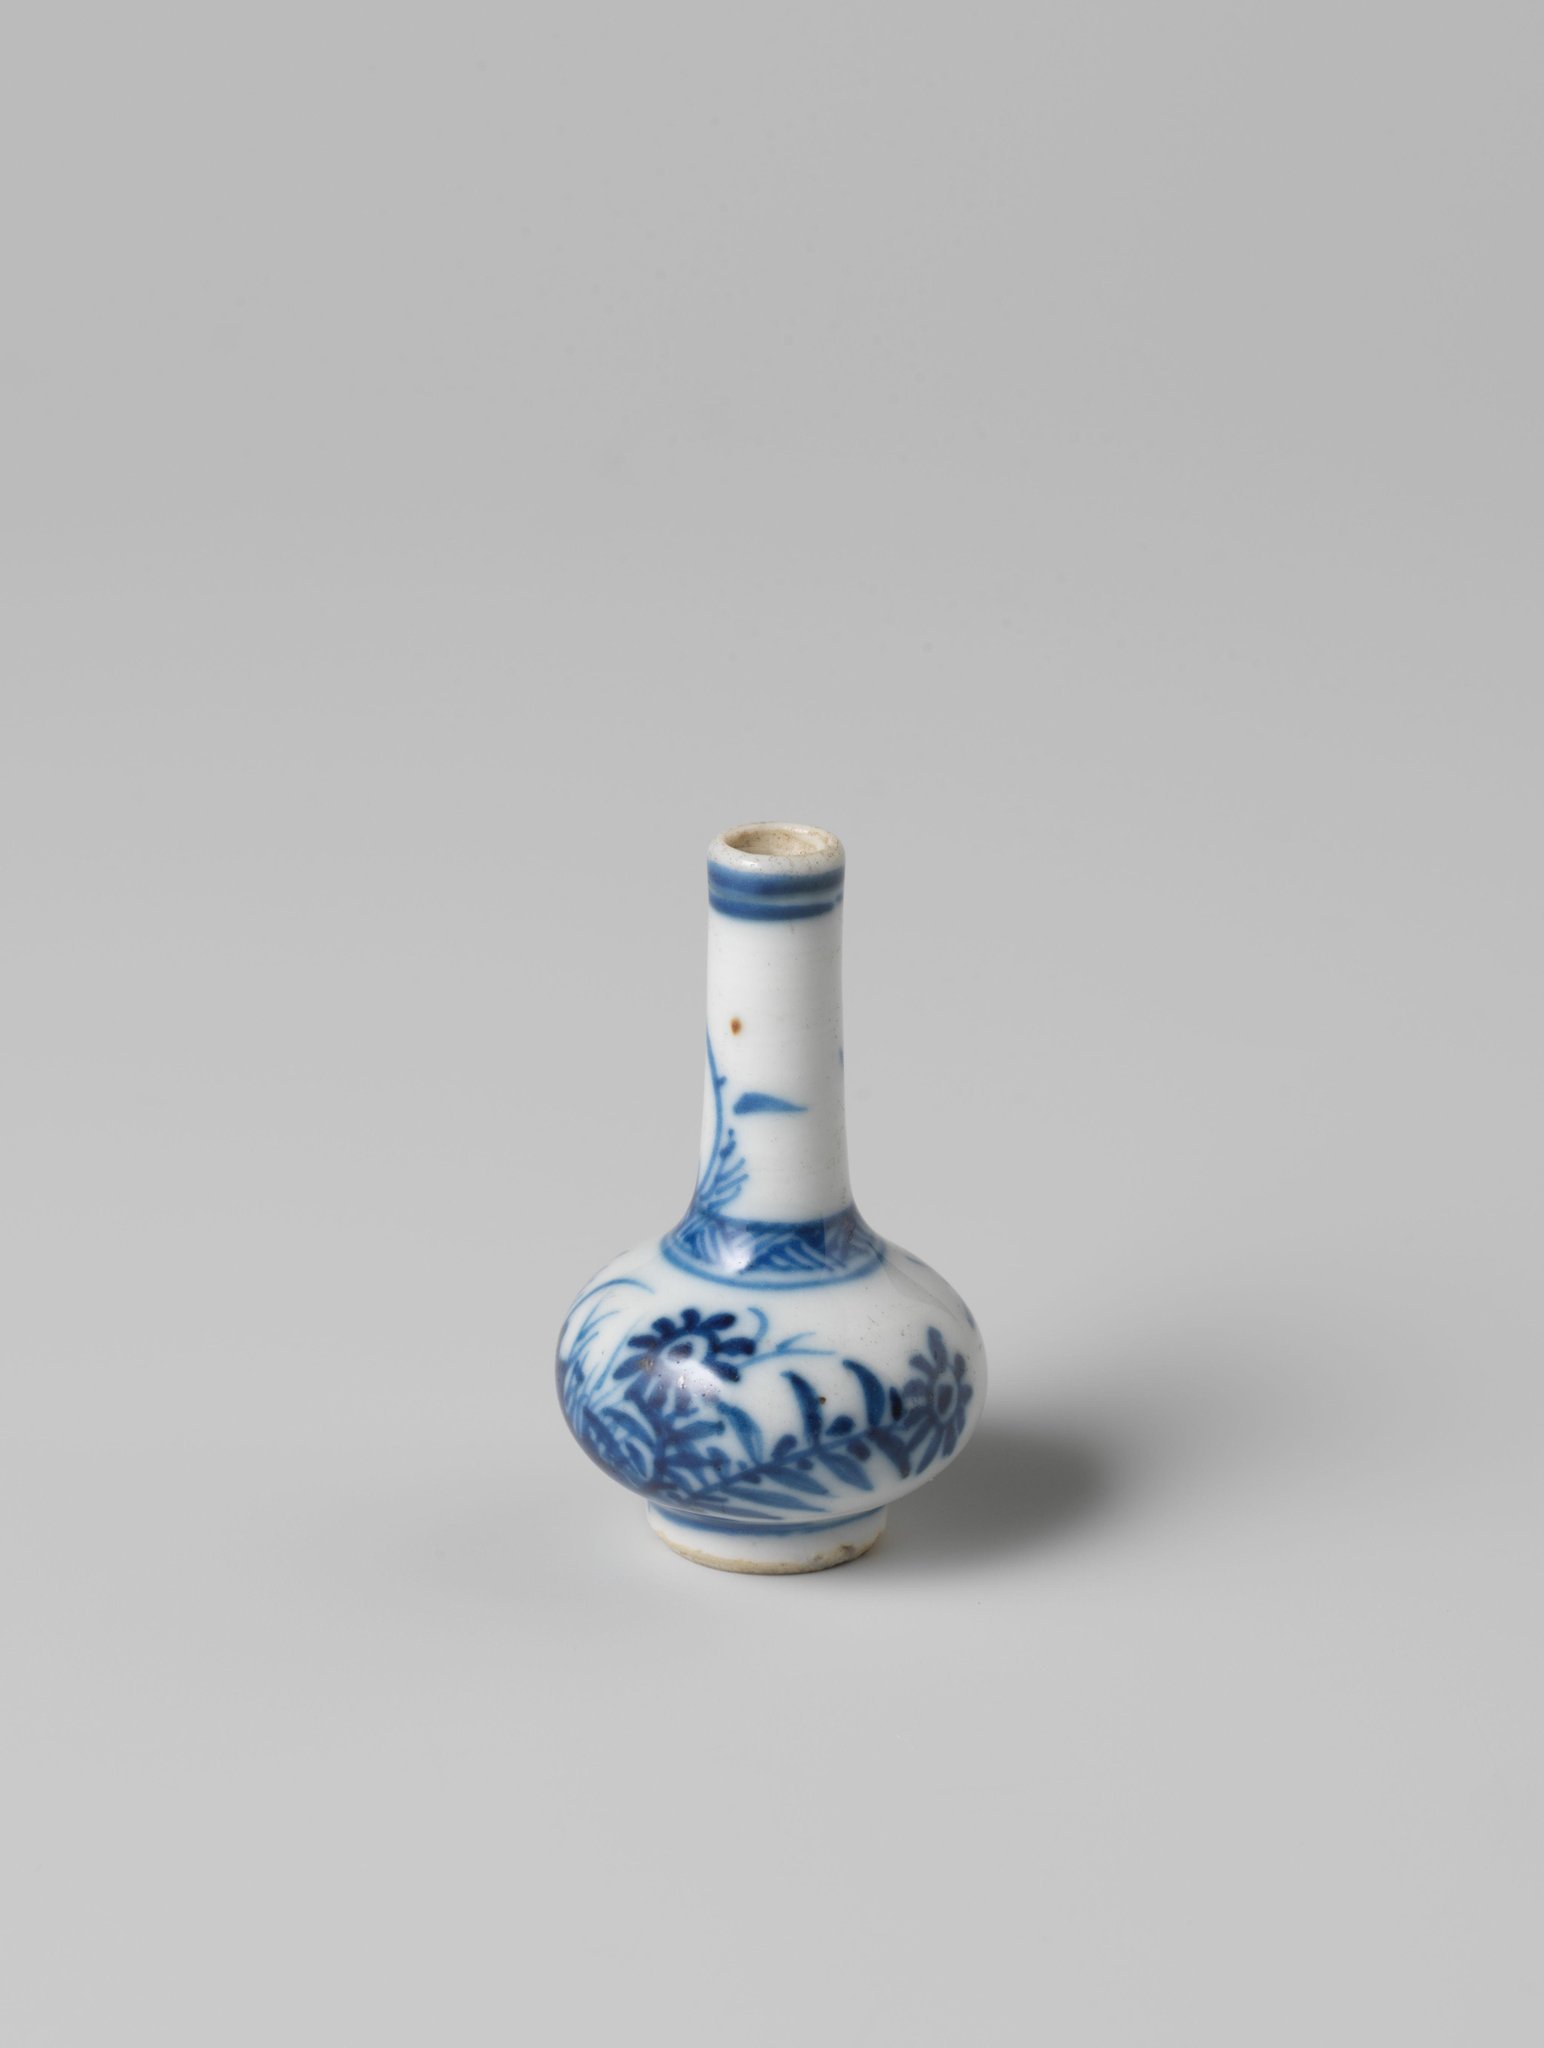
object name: vase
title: Miniature bottle vase with flowering plants and an insect near a rock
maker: Anonymous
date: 1675-1724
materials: cobalt, glaze, paint, porcelain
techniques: firing, turning, vitrification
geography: china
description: Vaas van porselein, flesvormig, beschilderd in onderglazuurblauw met plantmotieven.